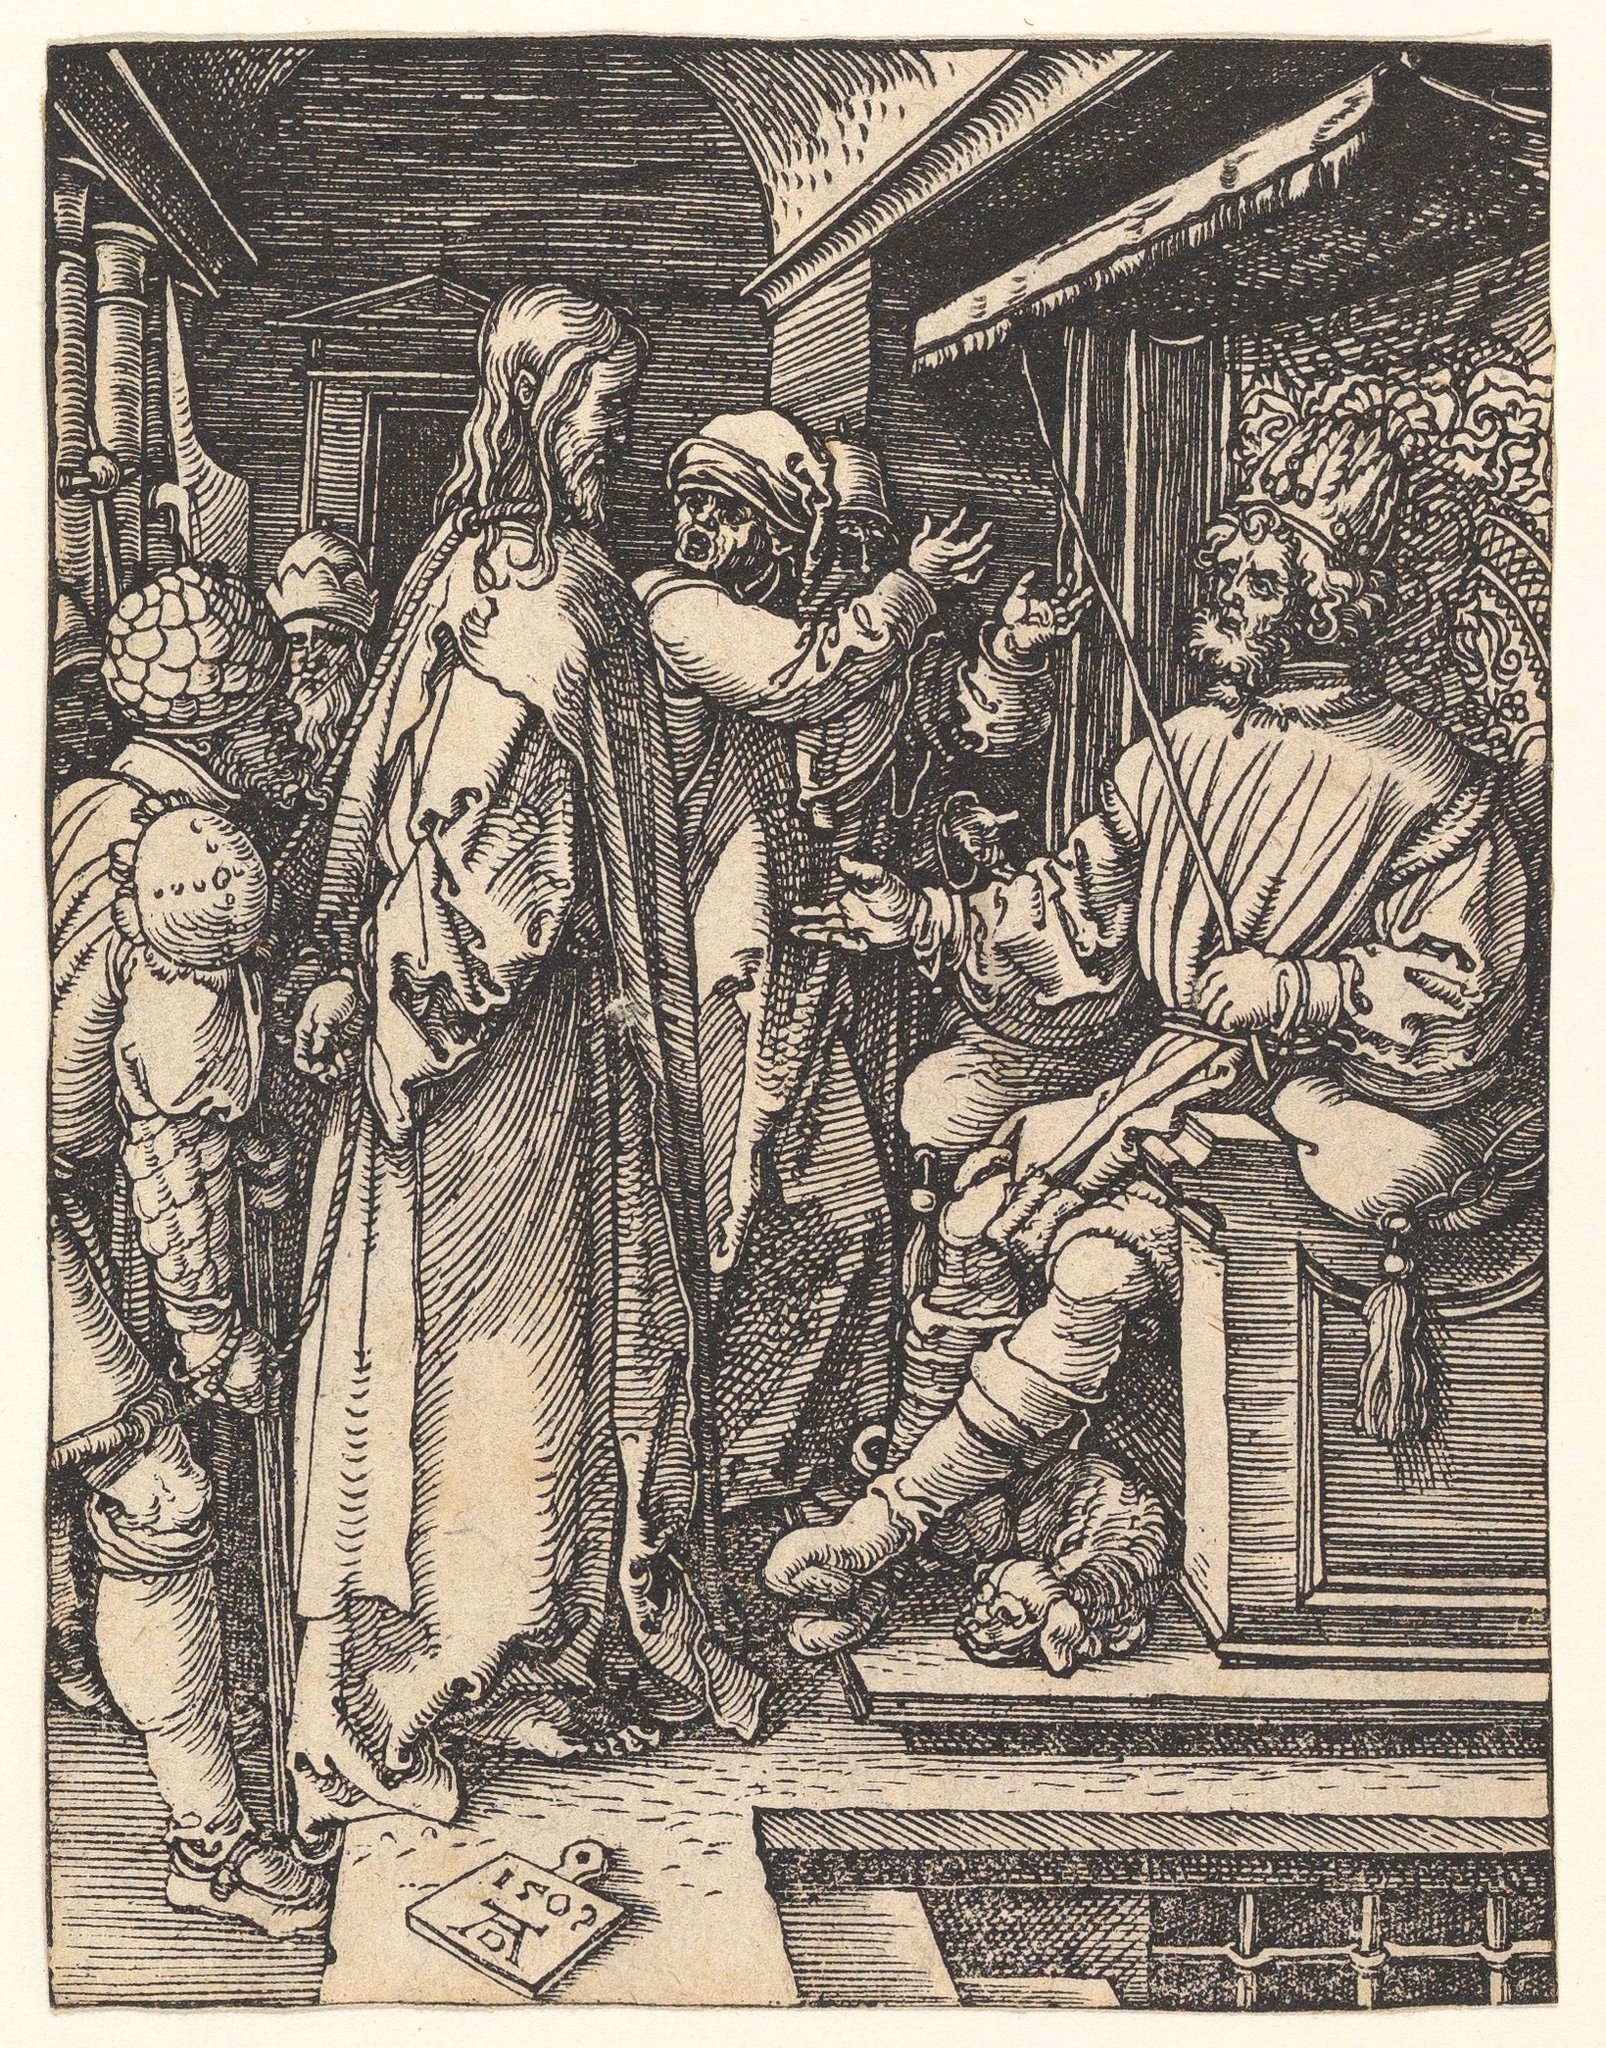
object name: print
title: Christ Before Herod, from "The Small Passion"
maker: albrecht dürer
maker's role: artist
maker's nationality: german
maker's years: 1471-1528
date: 1509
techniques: woodcut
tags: kings,men,christ